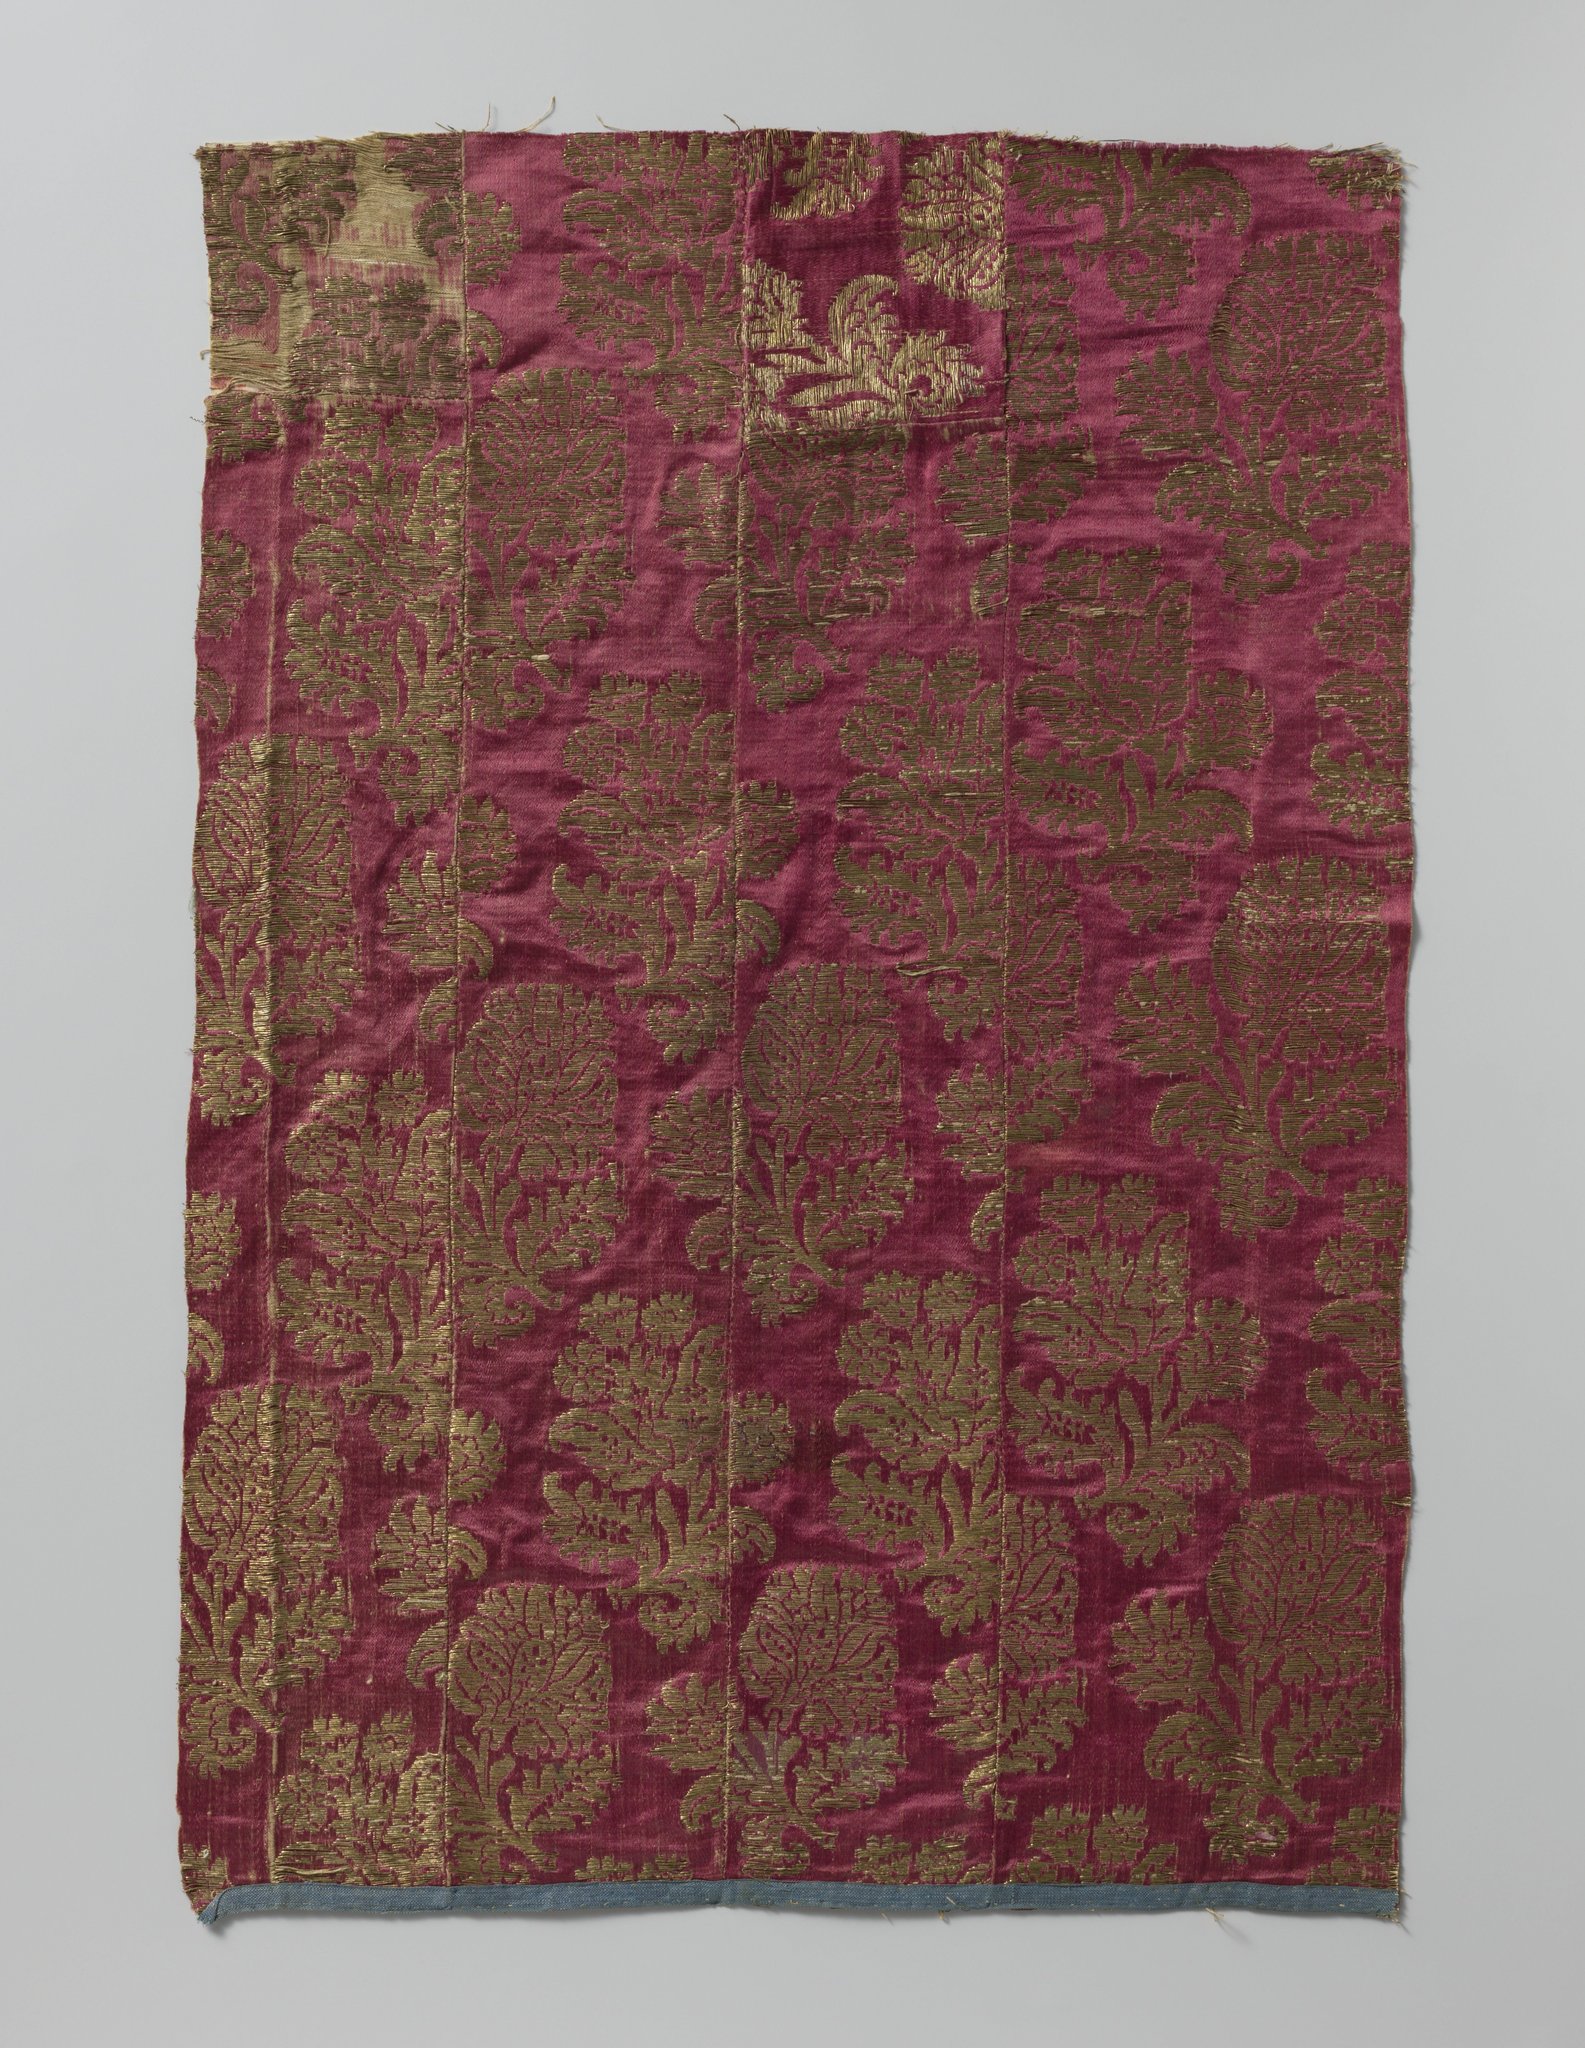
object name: zijdesatijn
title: Fragment wijnrood satijn met gouddraad, met patroon van grote en kleine bloemen aan takken met bladeren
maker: Anonymous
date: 1640-1700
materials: linen, silk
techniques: brocade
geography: germany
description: Fragment wijnrood satijn met gouddraad, met een patroon van grote en kleine bloemen aan takken met bladeren. Oosters textiel.